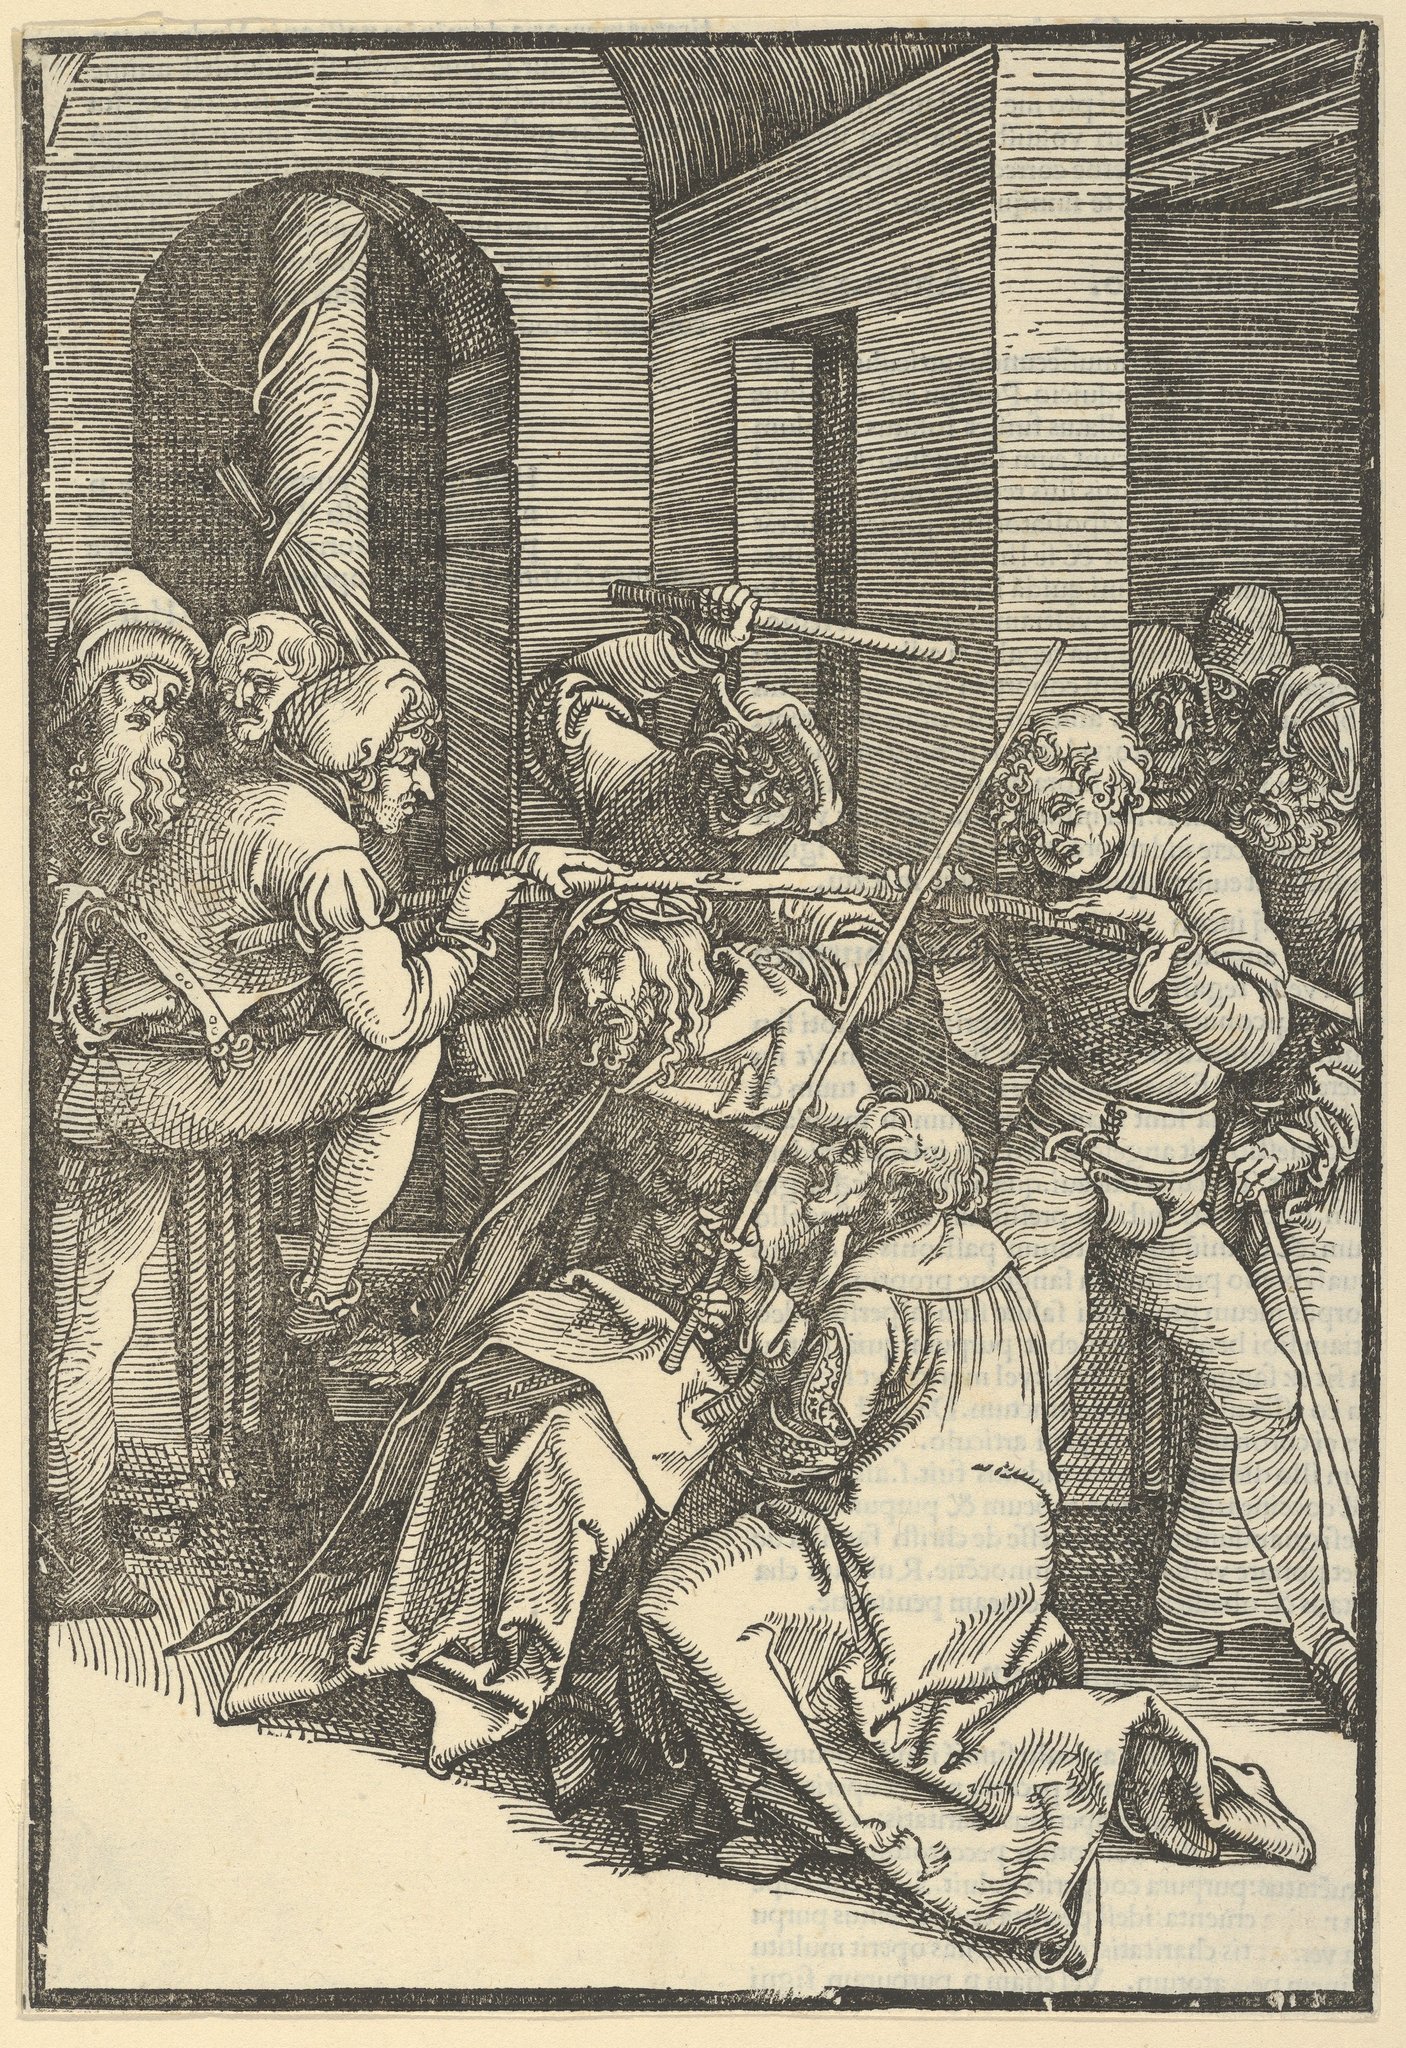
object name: print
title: Christ Crowned with Thorns, from Speculum passionis domini nostri Ihesu Christi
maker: hans schäufelein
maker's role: artist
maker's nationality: german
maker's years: 1480-1540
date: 1507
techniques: woodcut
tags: christ,jesus,crucifixion